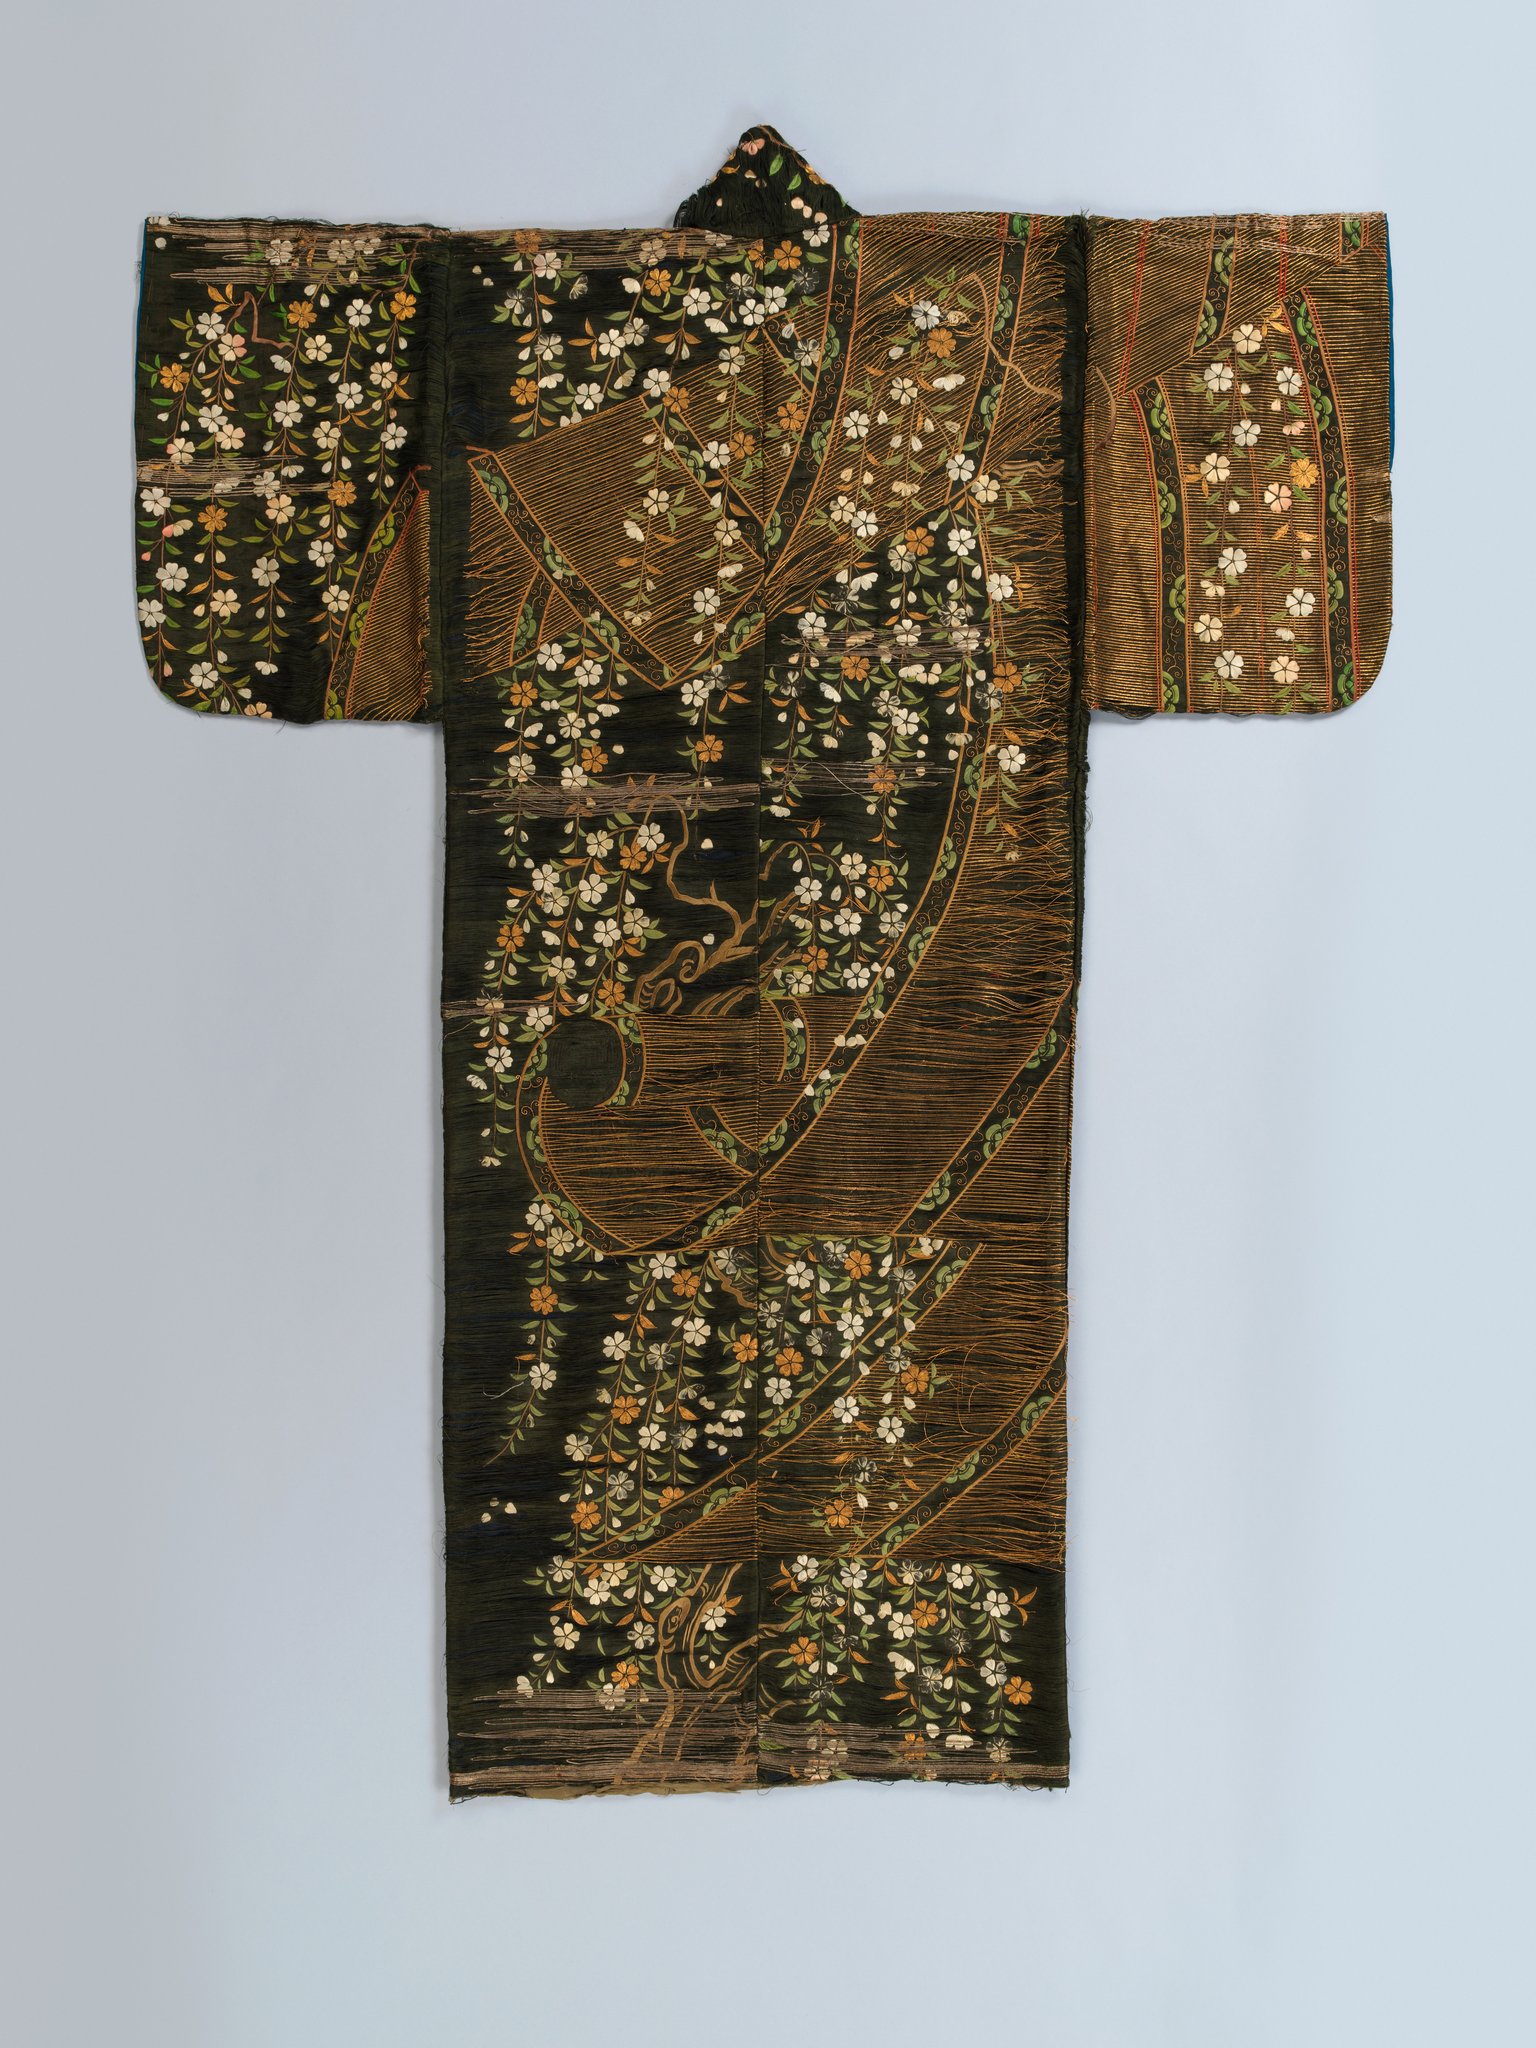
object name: robe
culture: japanese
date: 1751-1800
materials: silk